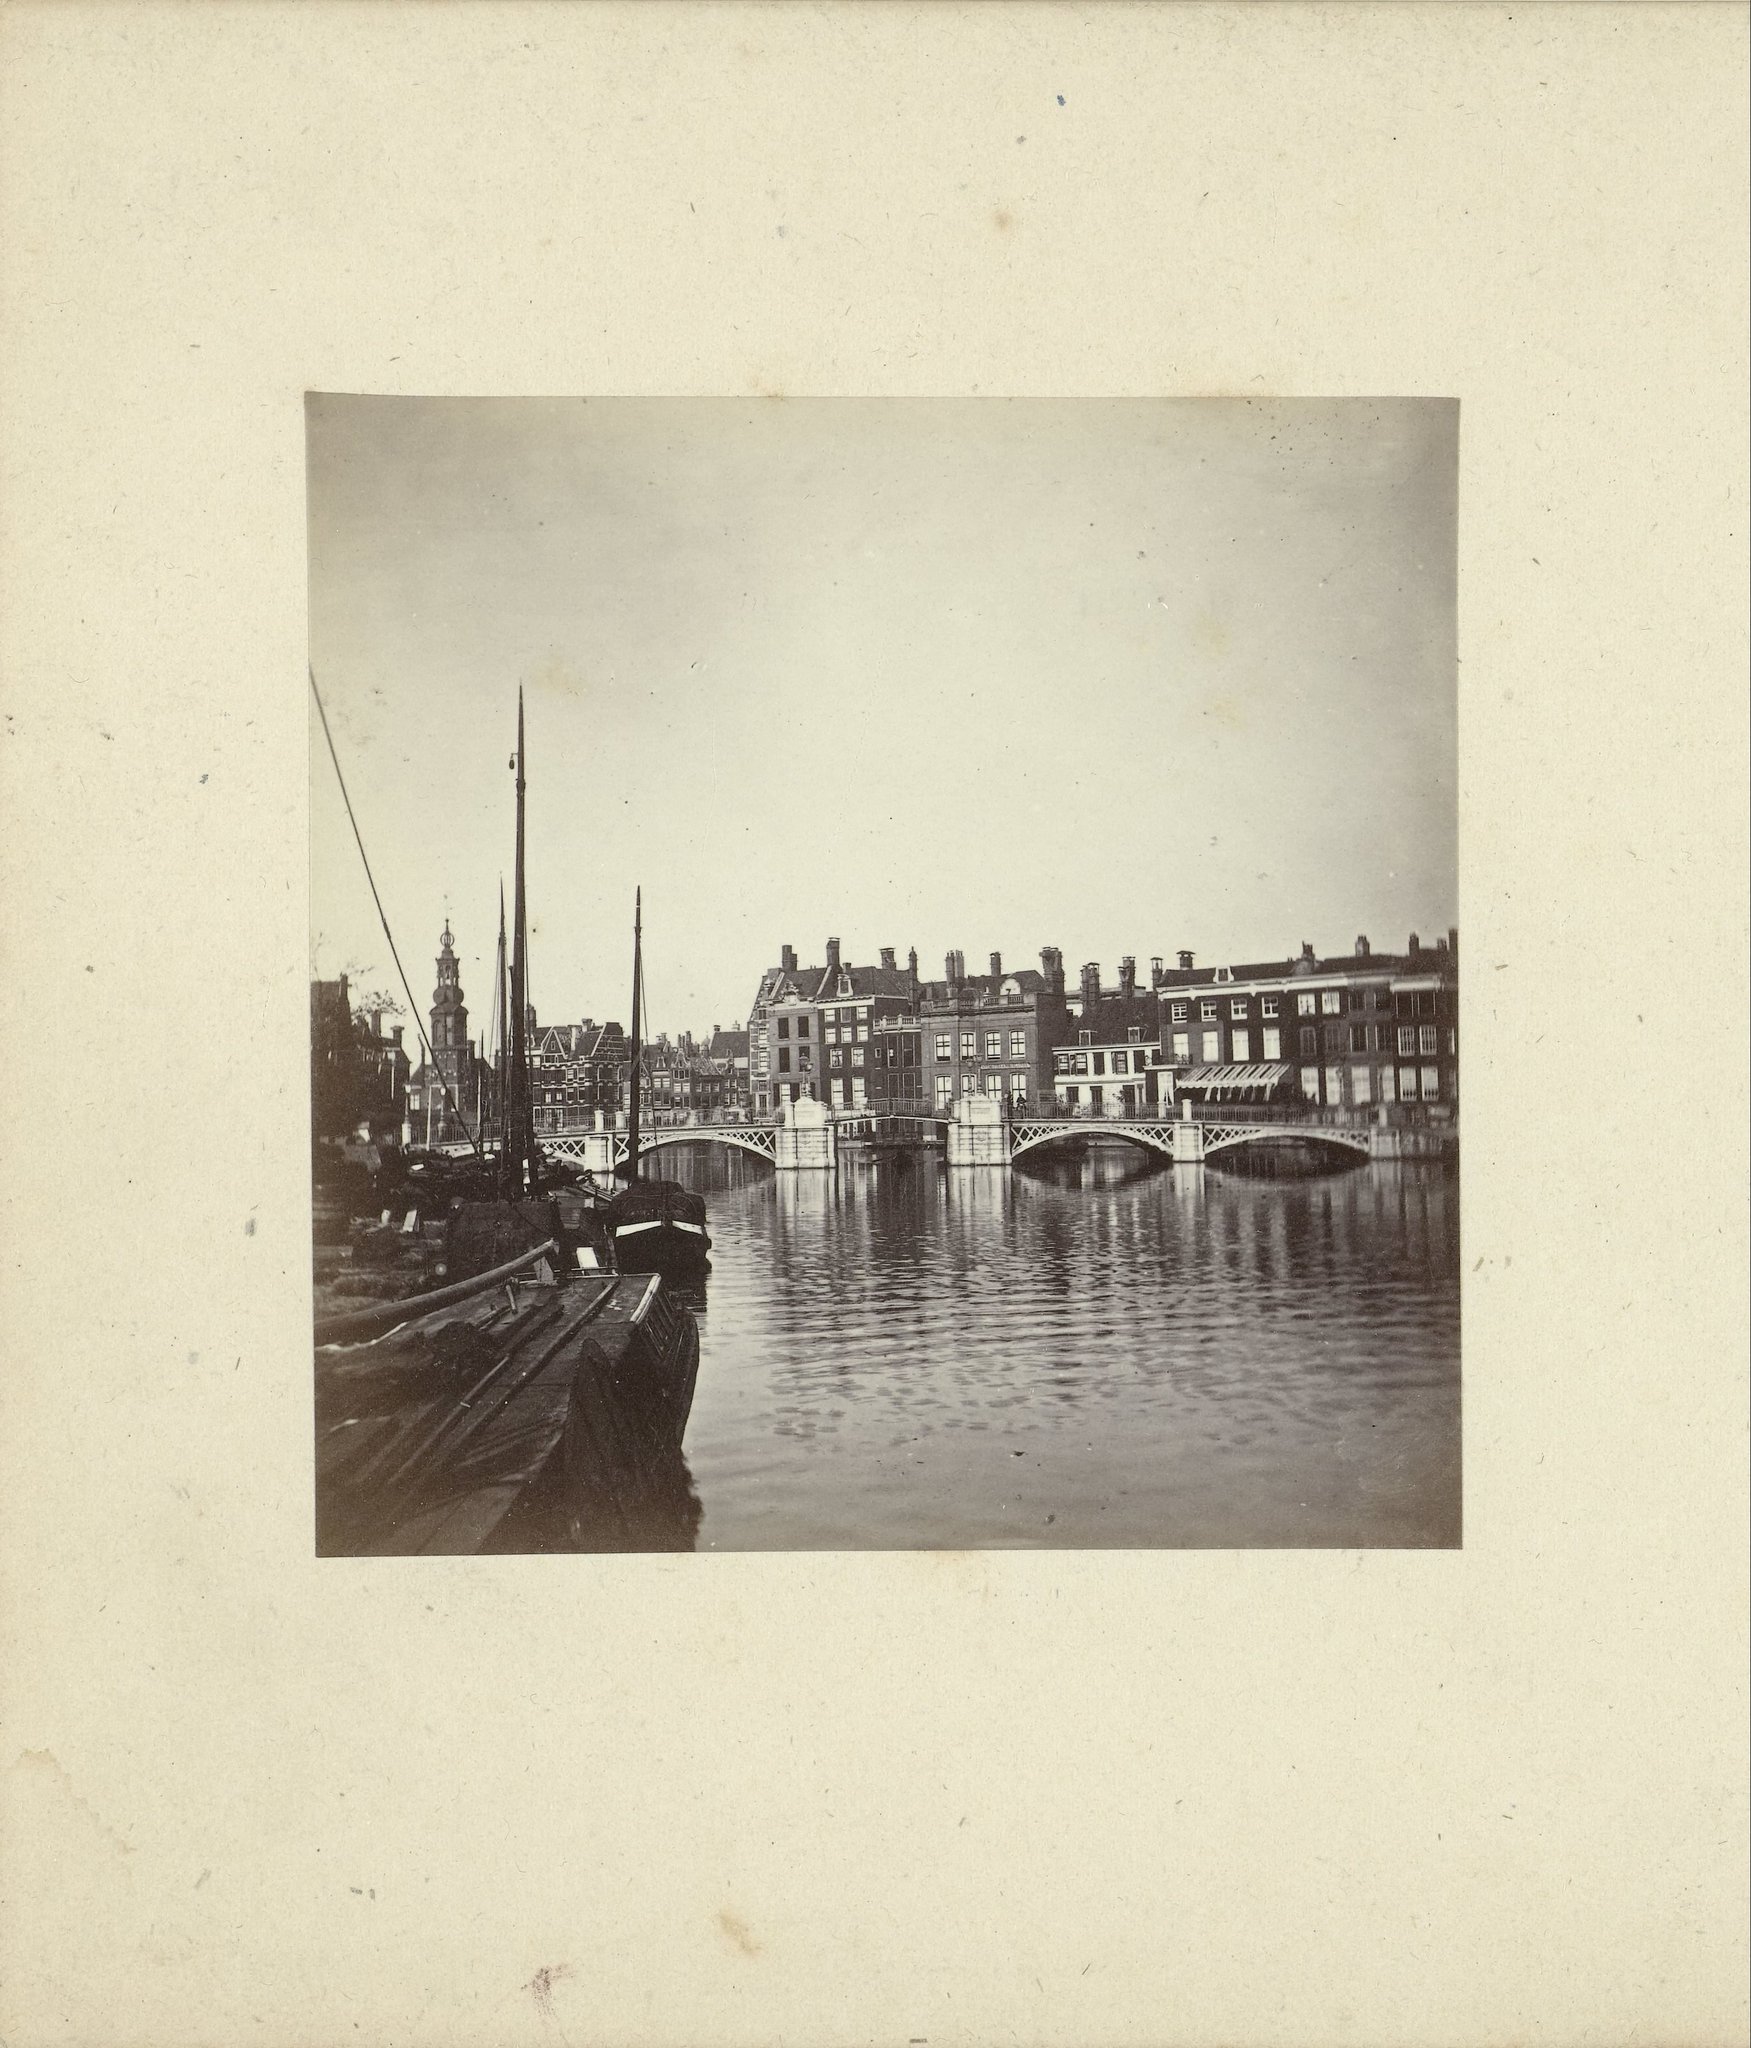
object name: photograph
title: De Binnen-Amstel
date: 1860-1875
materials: cardboard, paper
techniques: albumen print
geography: amsterdam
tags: bridge in city across river, canal, etc.